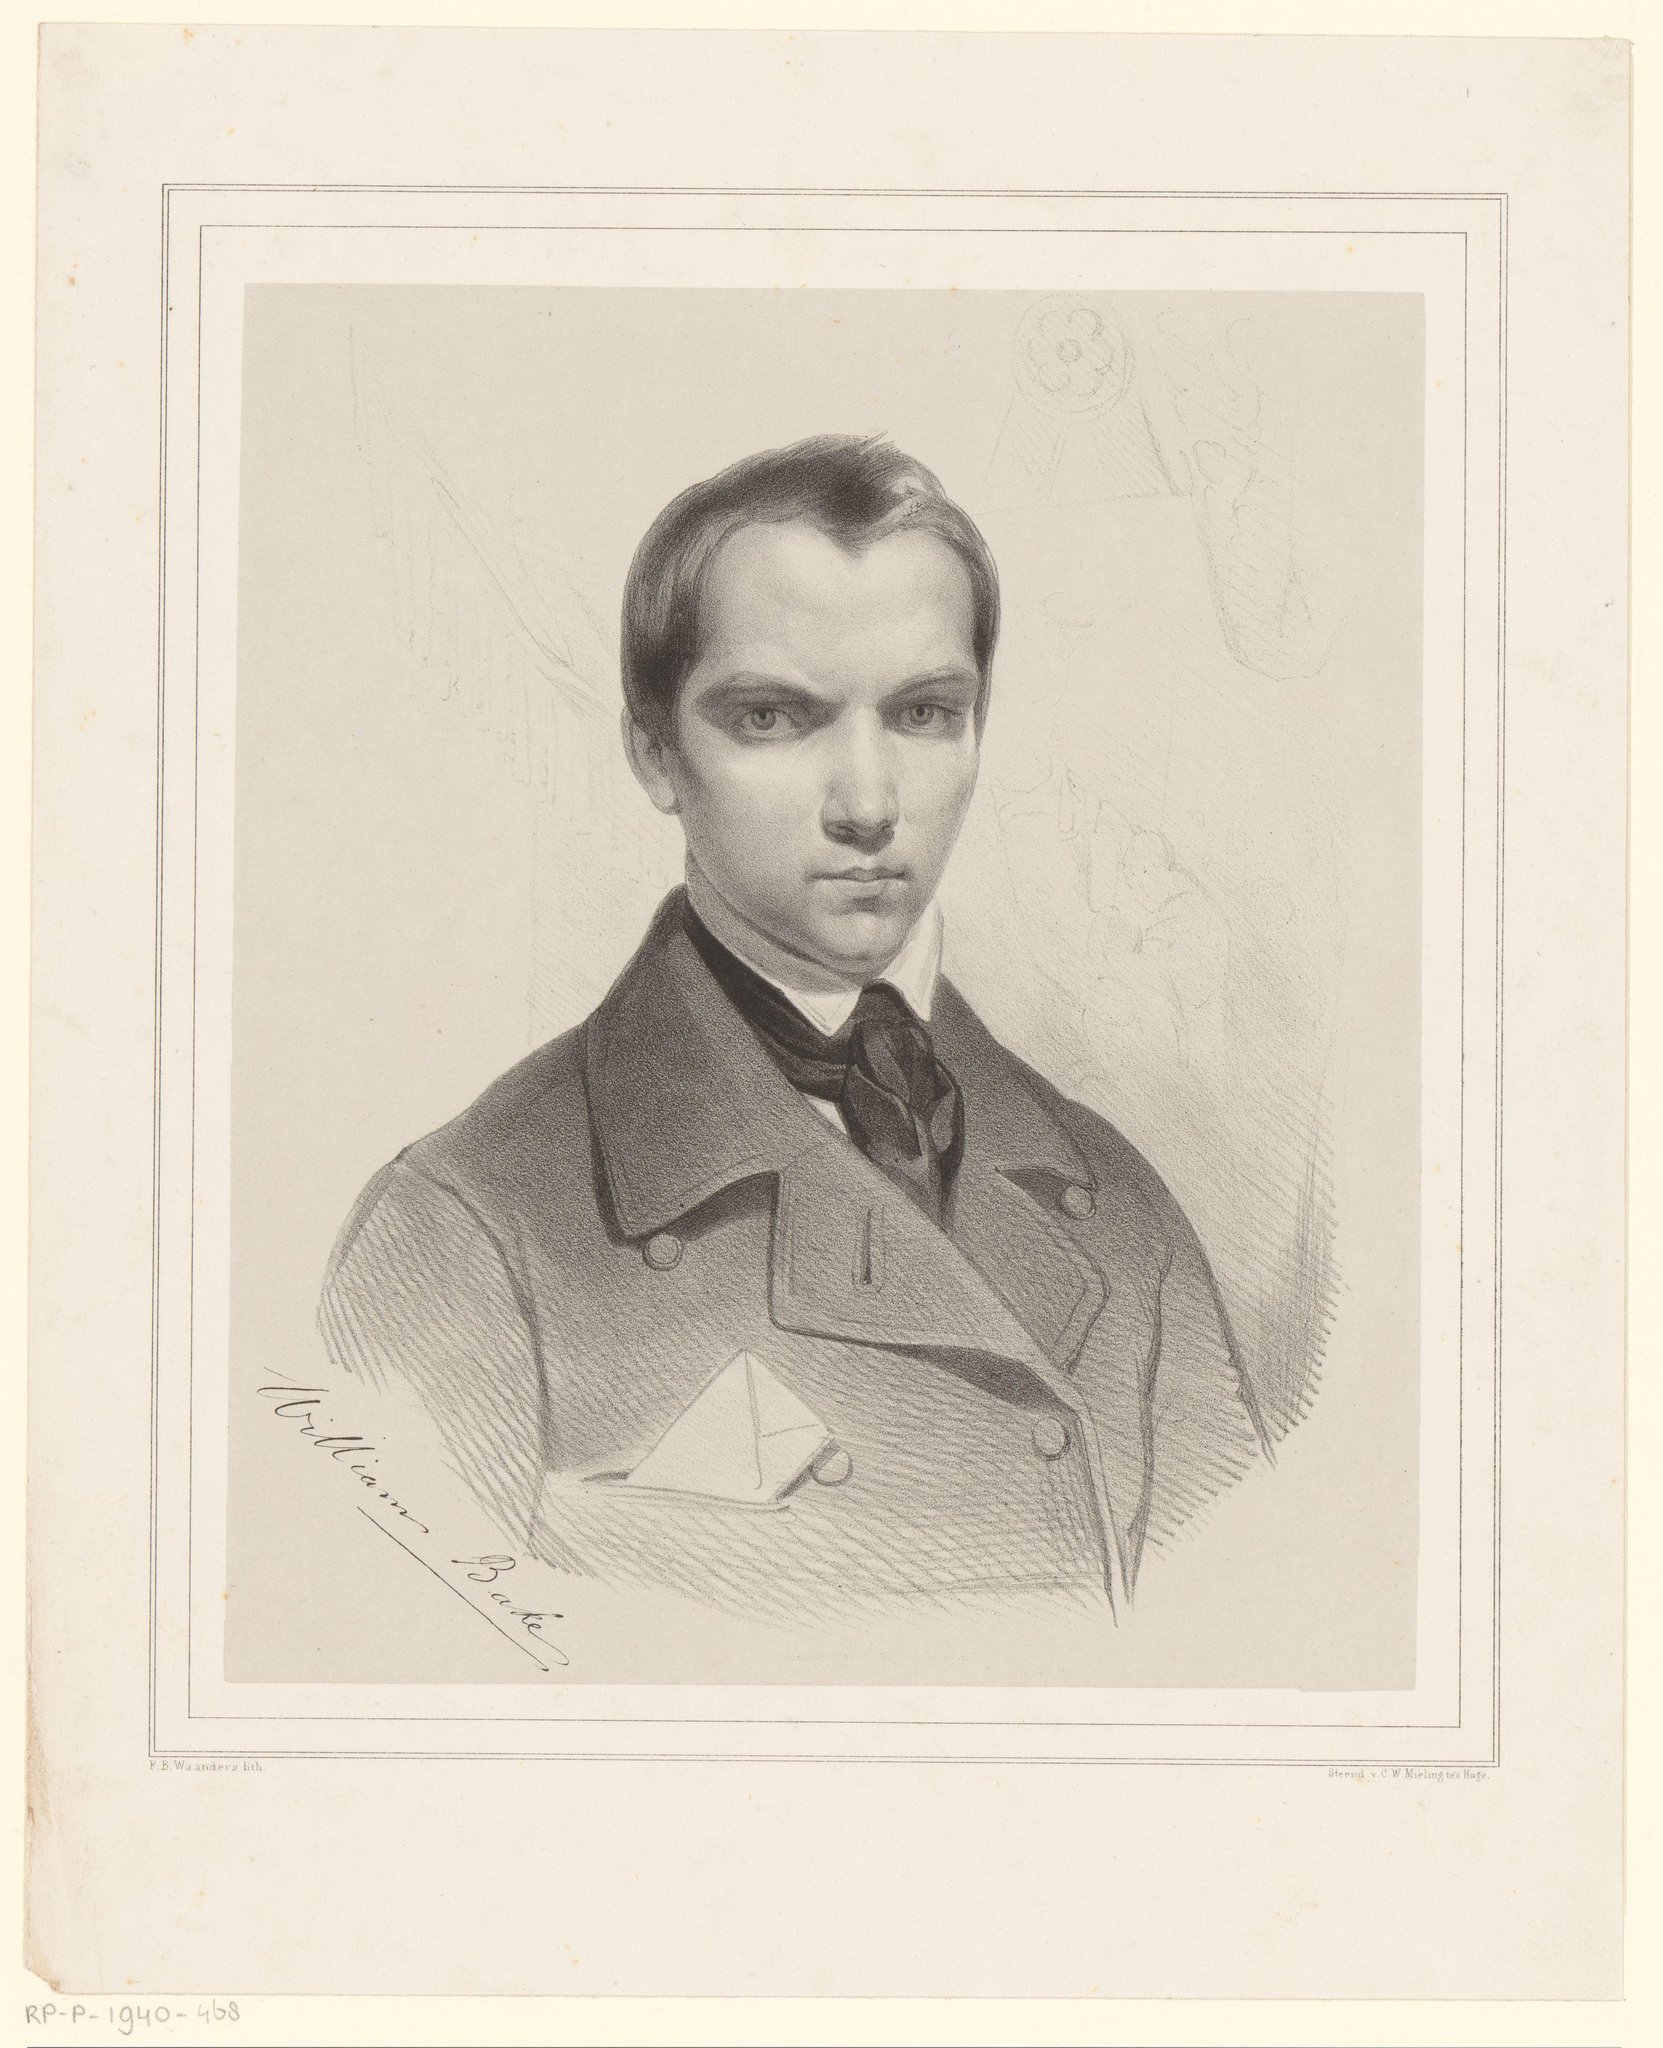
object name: print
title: Portret van William Bake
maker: franciscus bernardus waanders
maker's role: print maker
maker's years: 1809-1880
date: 1847-1865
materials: paper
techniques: lithograph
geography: the hague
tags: historical persons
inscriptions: collector's mark: Lugt 2228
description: Onder het portret de signatuur van de geportretteerde.